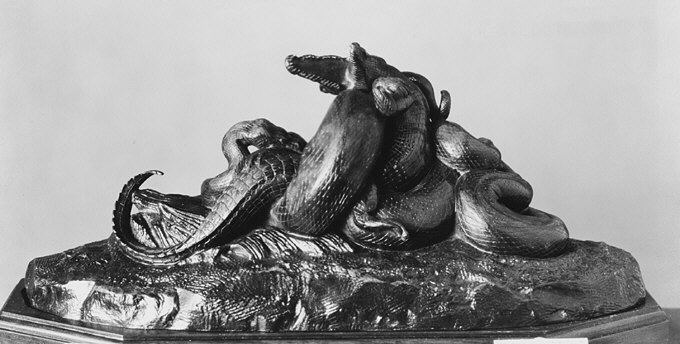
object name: statuette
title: Python Crushing a Crocodile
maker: antoine-louis barye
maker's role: artist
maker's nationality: french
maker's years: 1795-1875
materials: bronze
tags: crocodiles,snakes